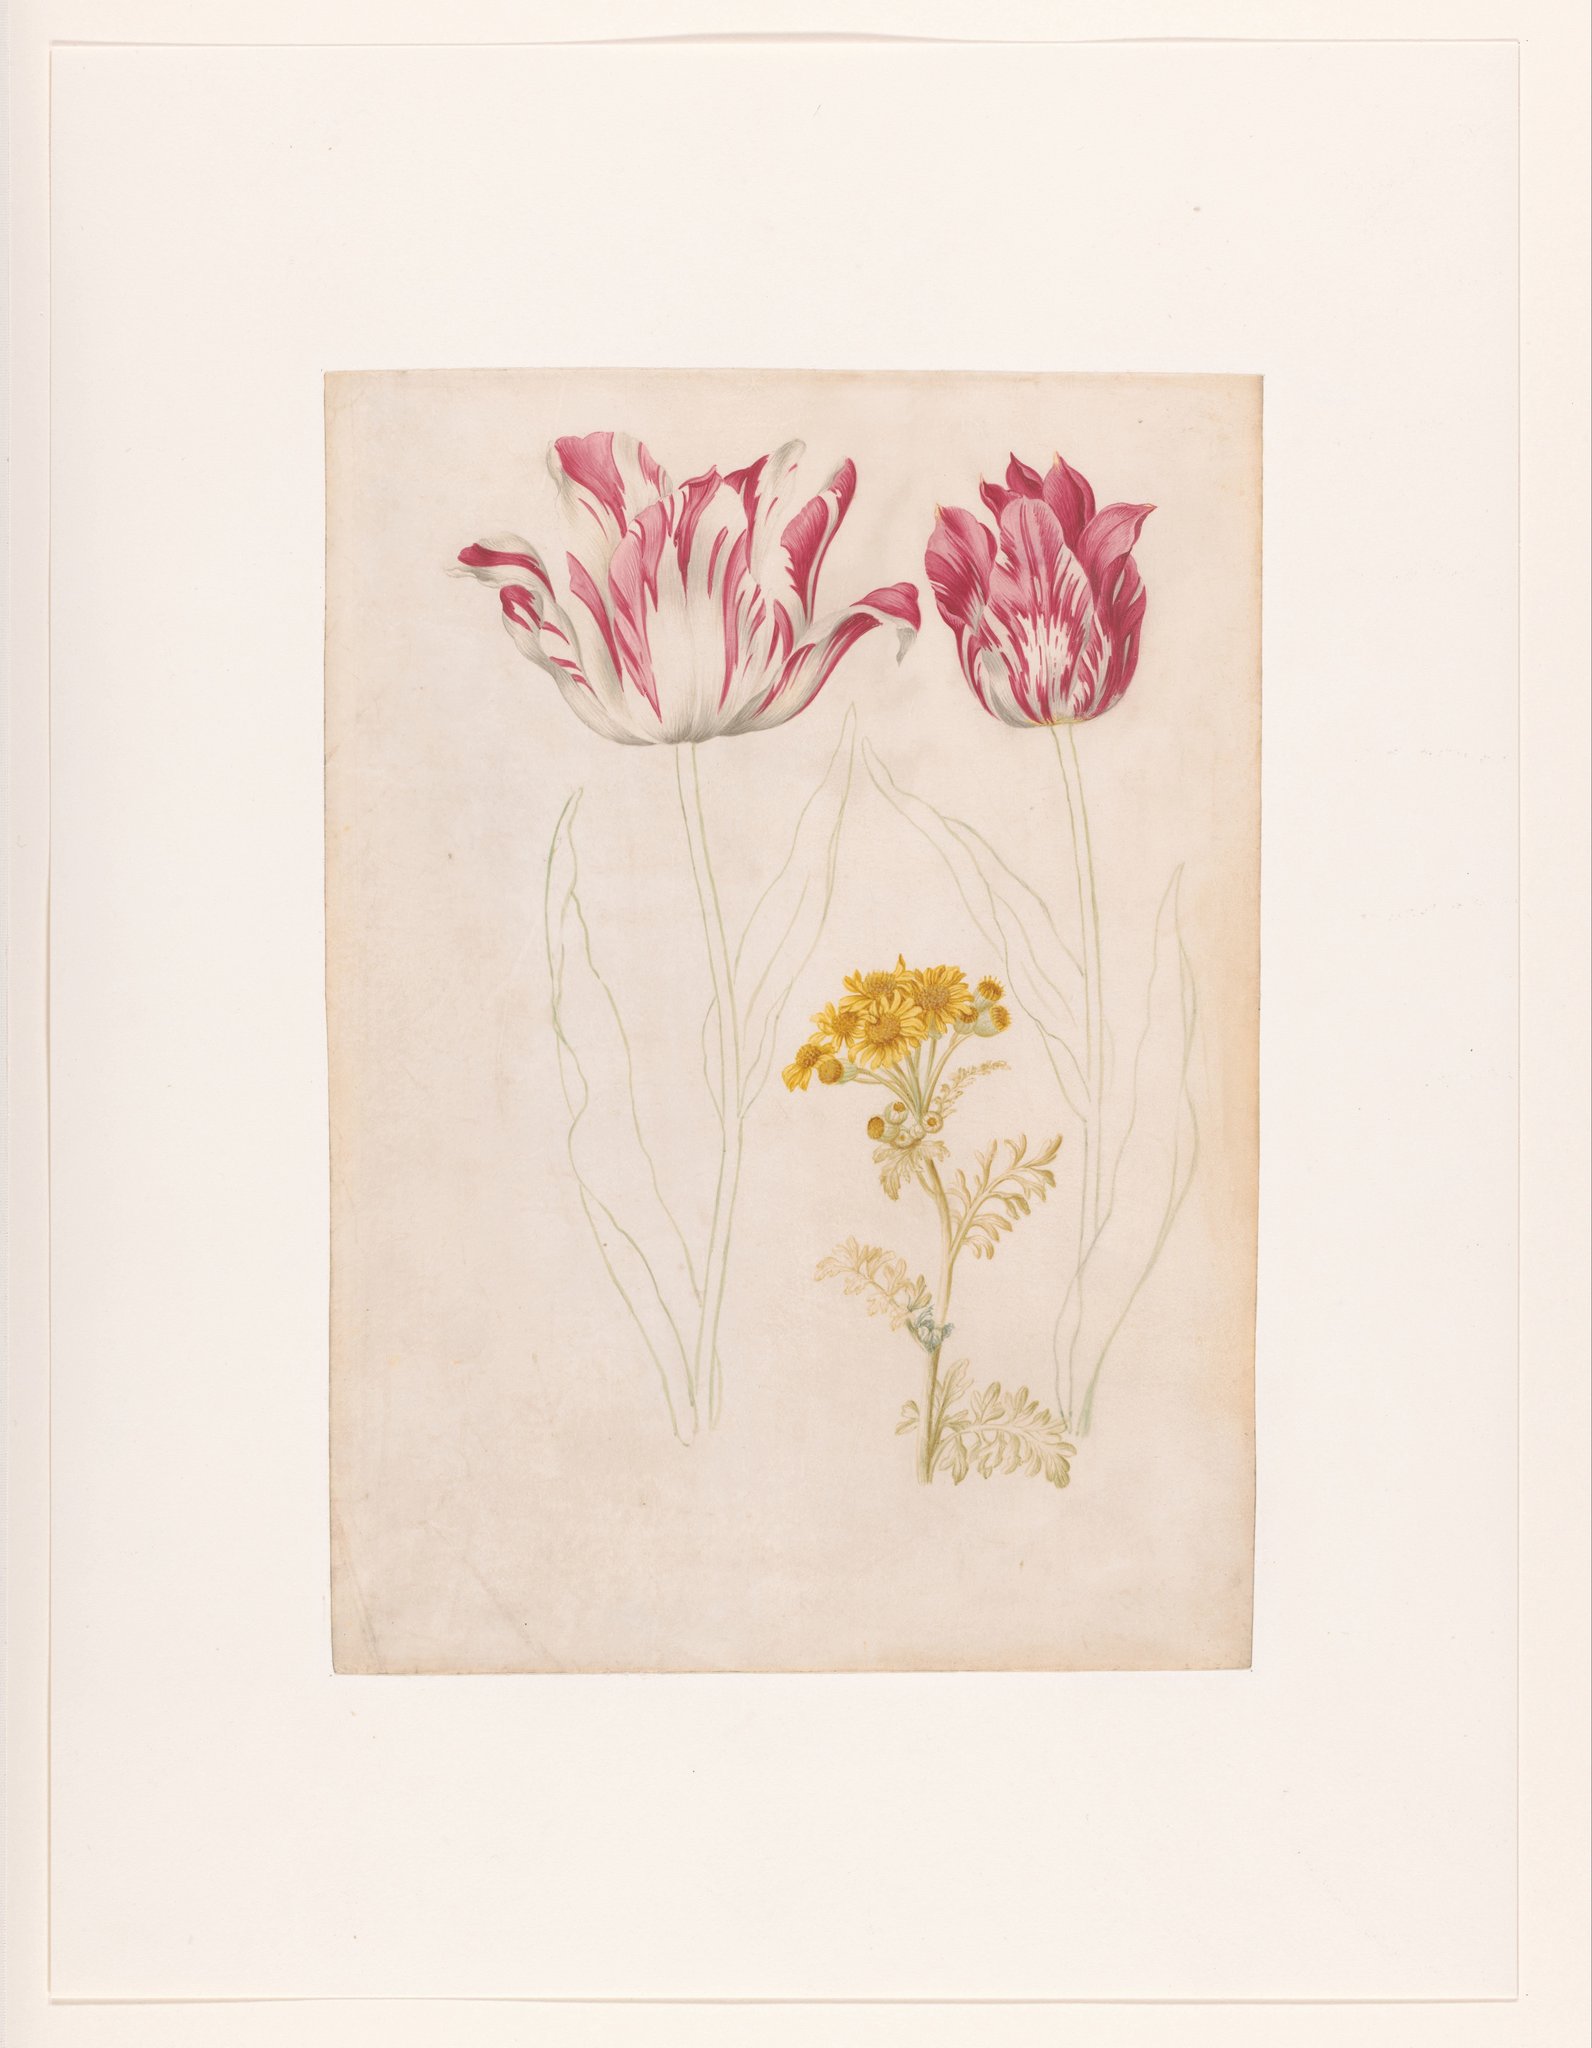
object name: drawing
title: Twee tulpen en een takje met gele bloemen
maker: jacob marrel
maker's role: draughtsman, painter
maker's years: 1614-1681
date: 1624-1681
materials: gouache, parchment, watercolor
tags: flowers: tulip